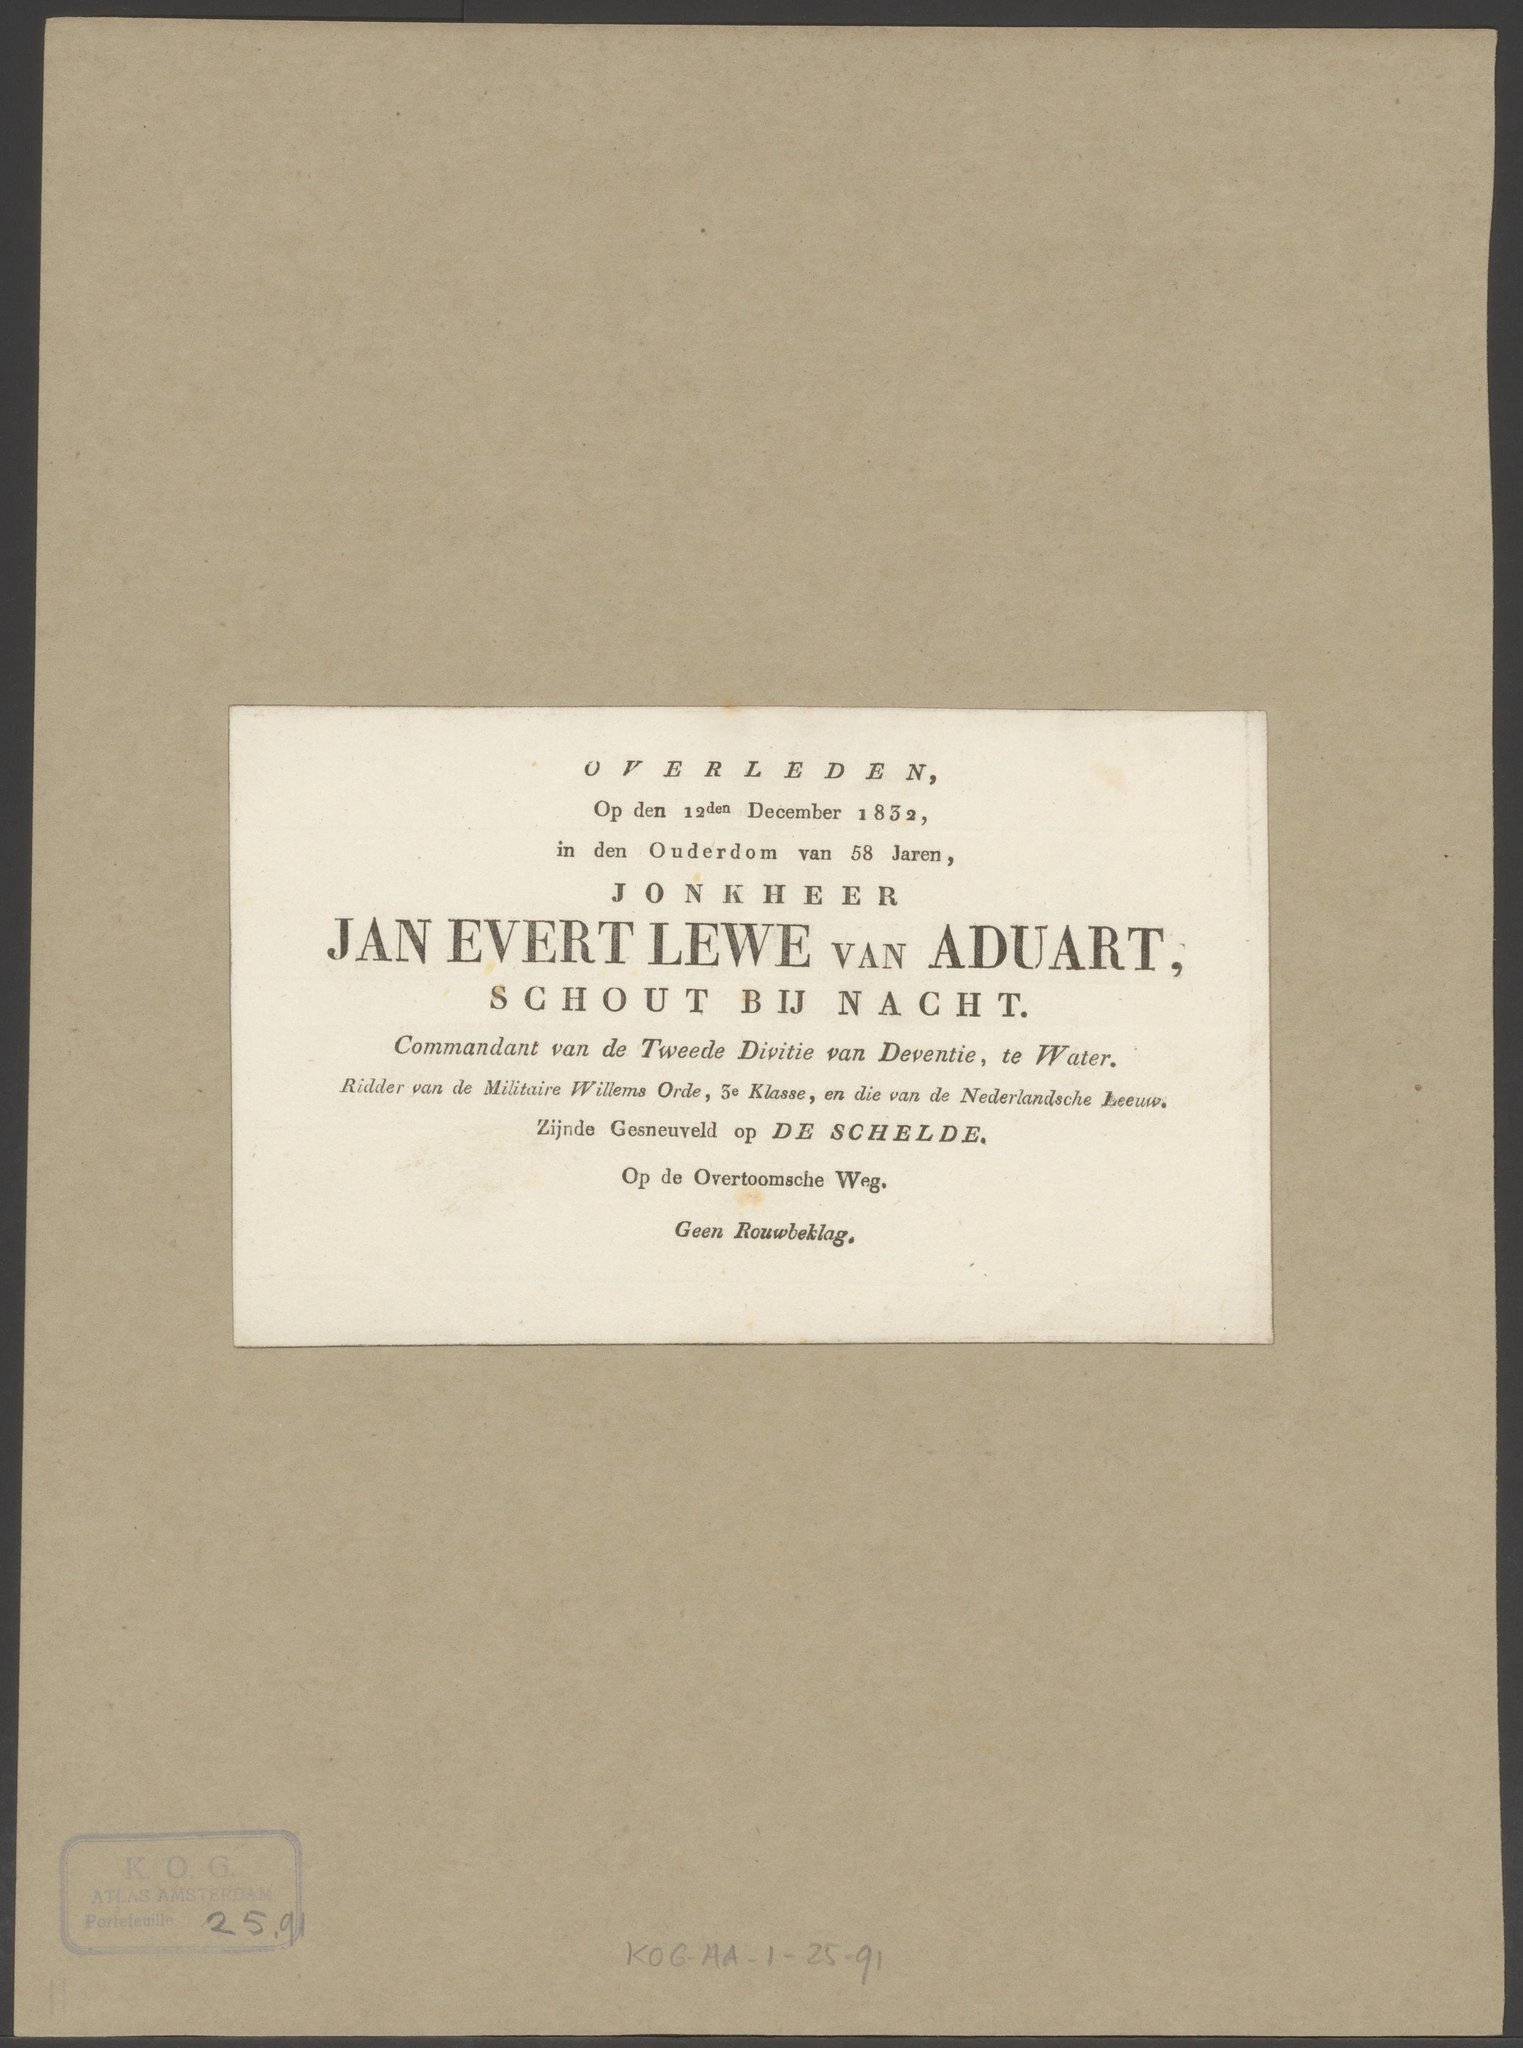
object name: text sheet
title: Overlijdensbericht van Jan Evert Lewe van Aduard, 12 december 1832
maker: Anonymous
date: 1832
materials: paper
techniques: letterpress printing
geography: amsterdam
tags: announcement of death, amsterdam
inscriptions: collector's mark: ‘25.91’ Lugt 1641b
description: Onderwerpsrubriek binnen de Atlas Amsterdam: Krijgswezen I: De Admiraliteit van Amsterdam, B. Vlootvoogden en schepelingen; Herinneringen daaraan.